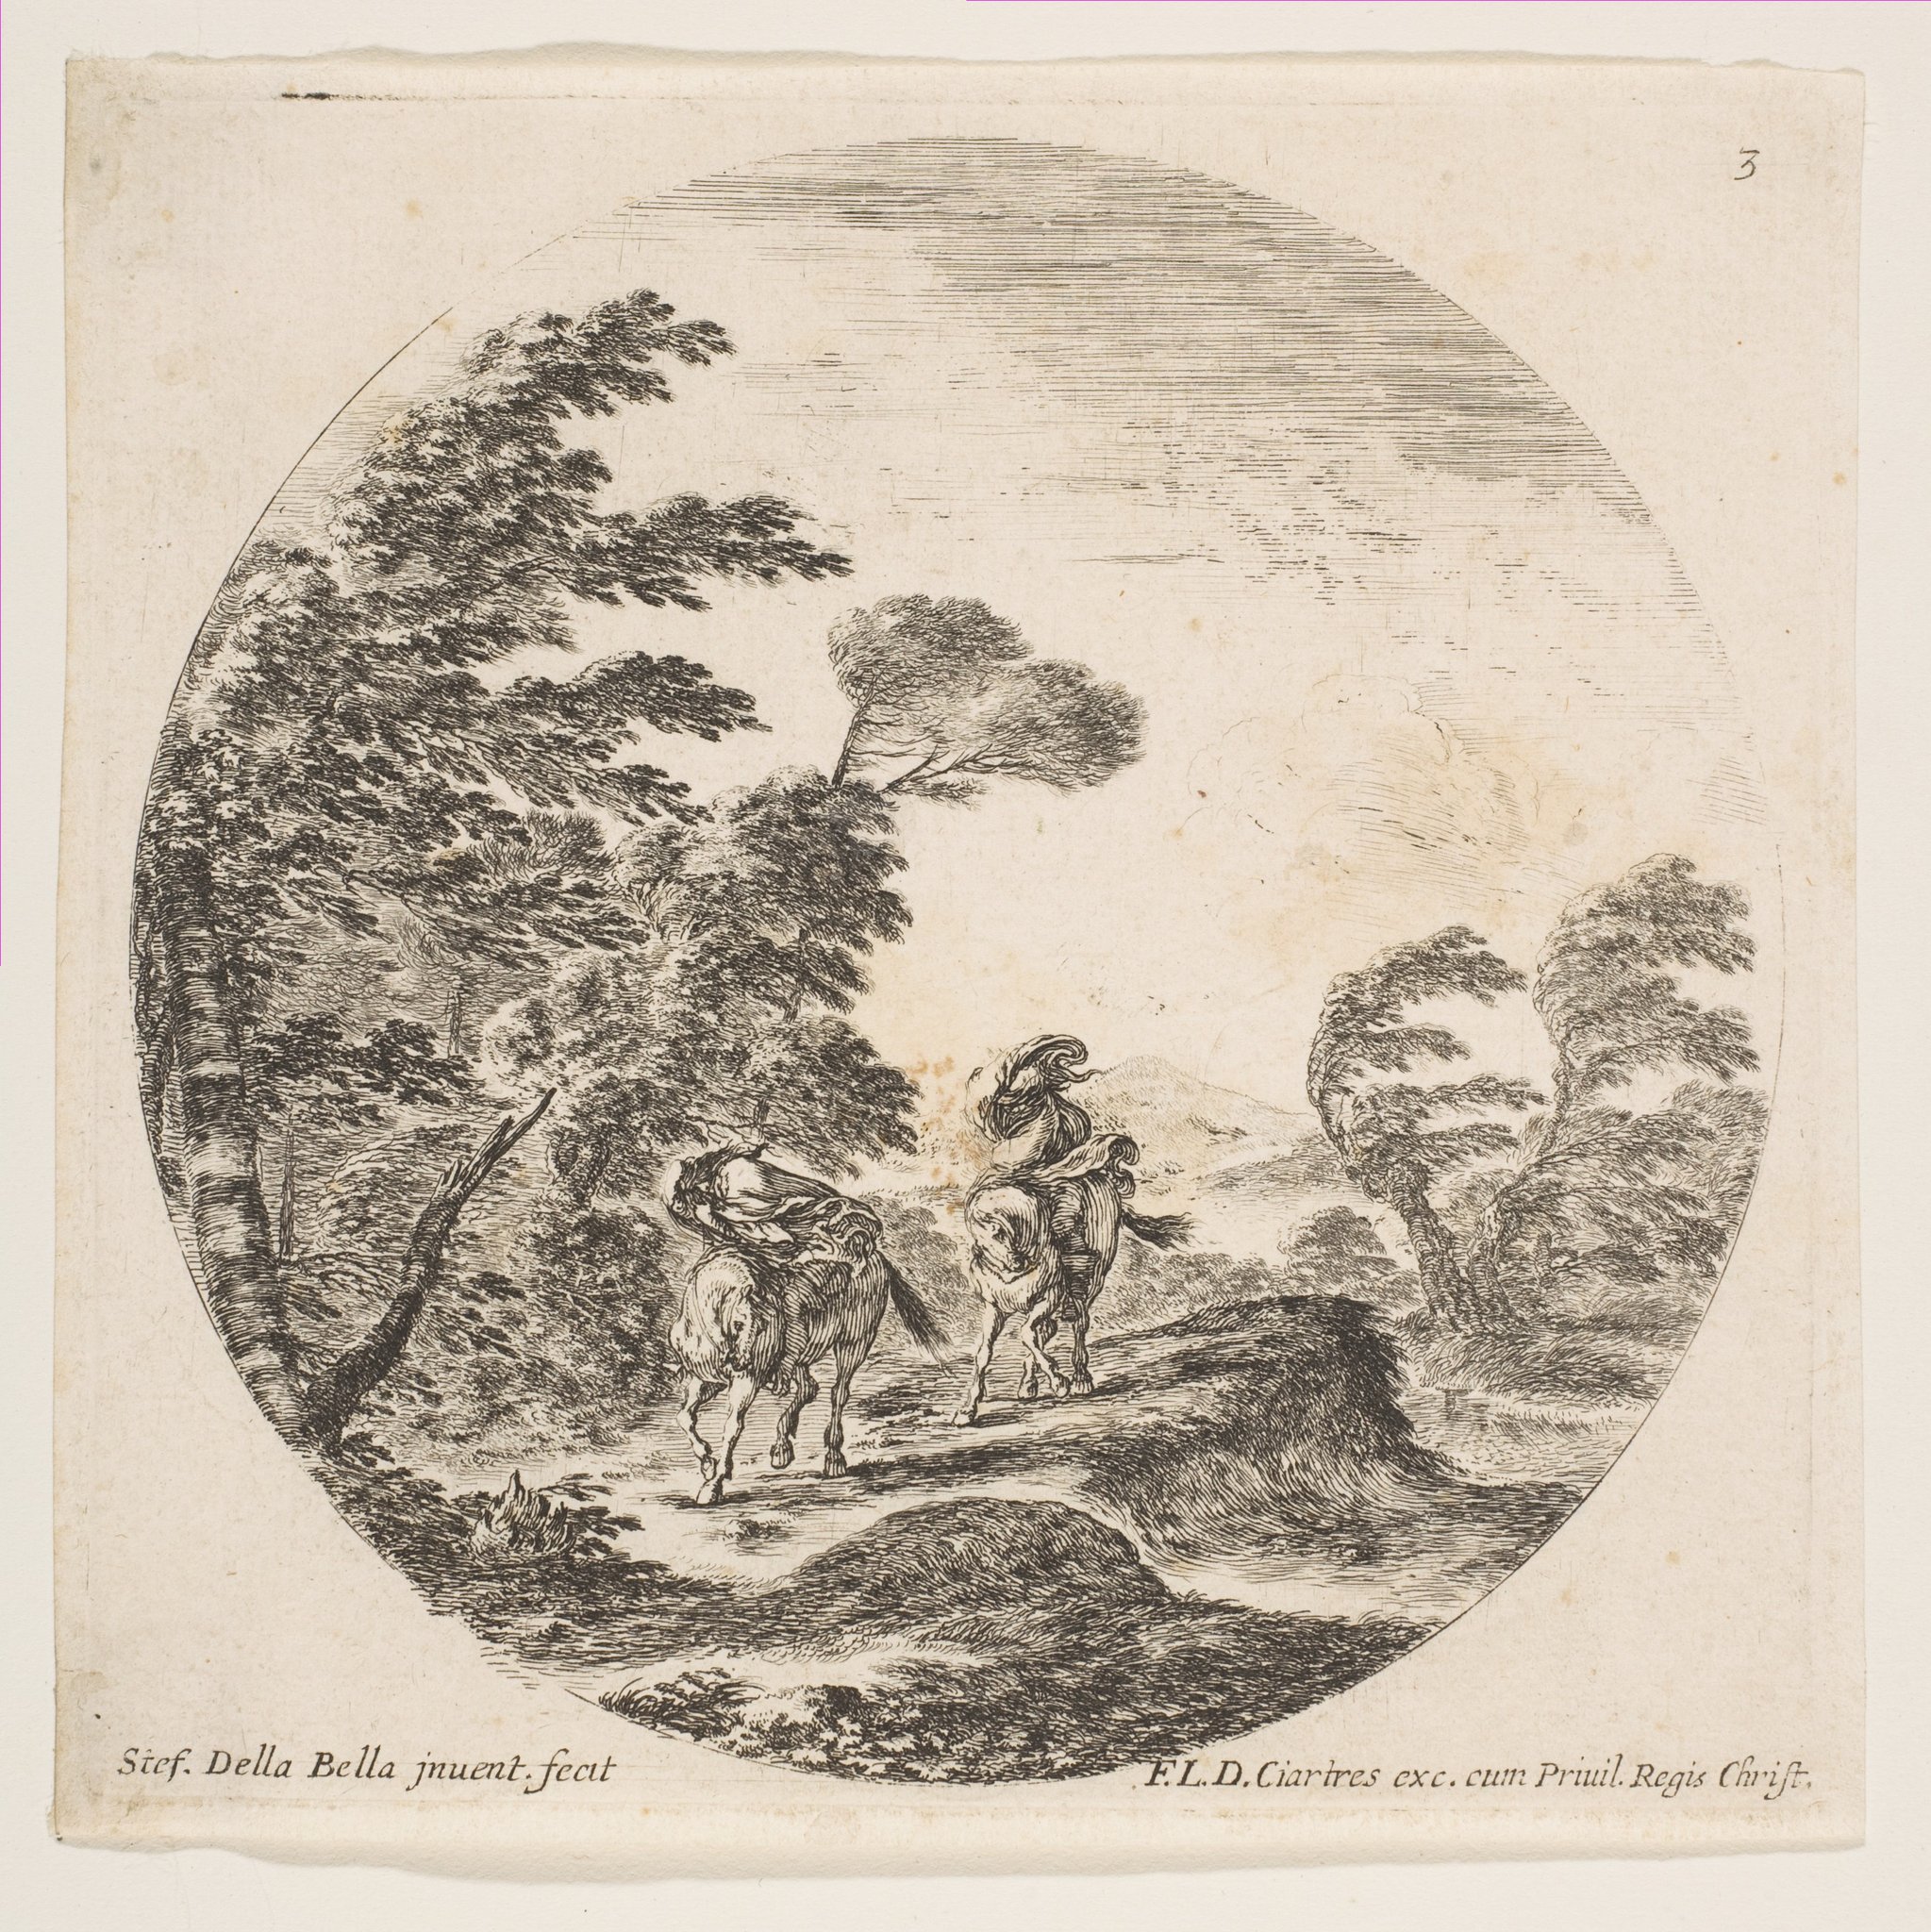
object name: print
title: A gale in the forest, two horsemen wrapped in their cloaks, with the wind blowing from the left side, plate 3 from "Roman landscapes and ruins" (Paysages et ruines de Rome)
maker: stefano della bella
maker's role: artist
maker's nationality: italian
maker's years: 1610-1664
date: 1646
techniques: etching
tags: men,horses,forests,wind